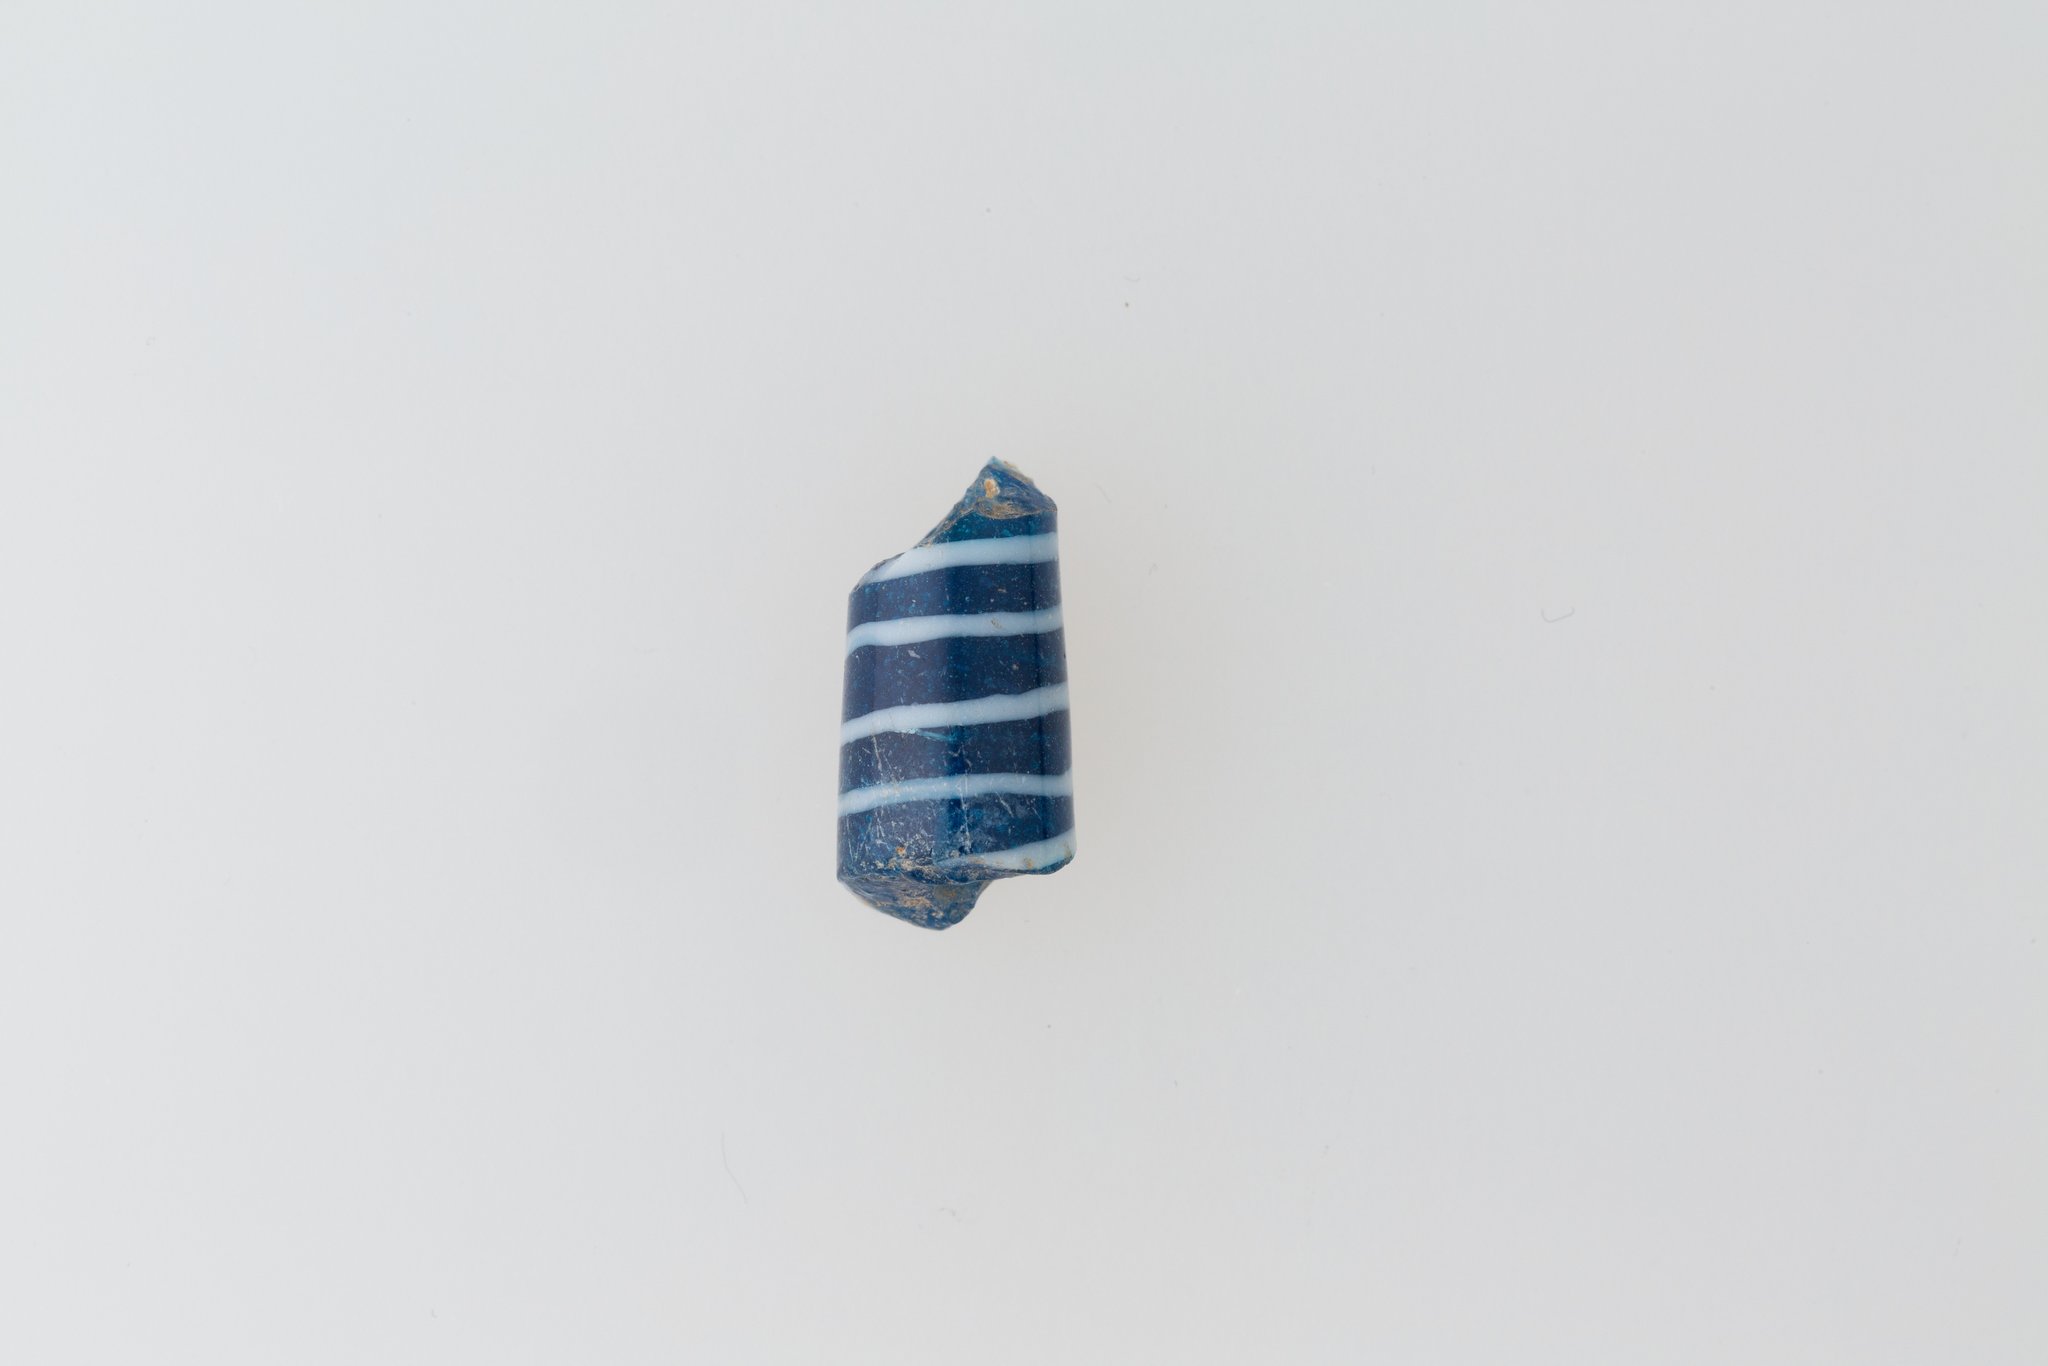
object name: part of an ear stud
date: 1390-1352 BCE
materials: glass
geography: egypt